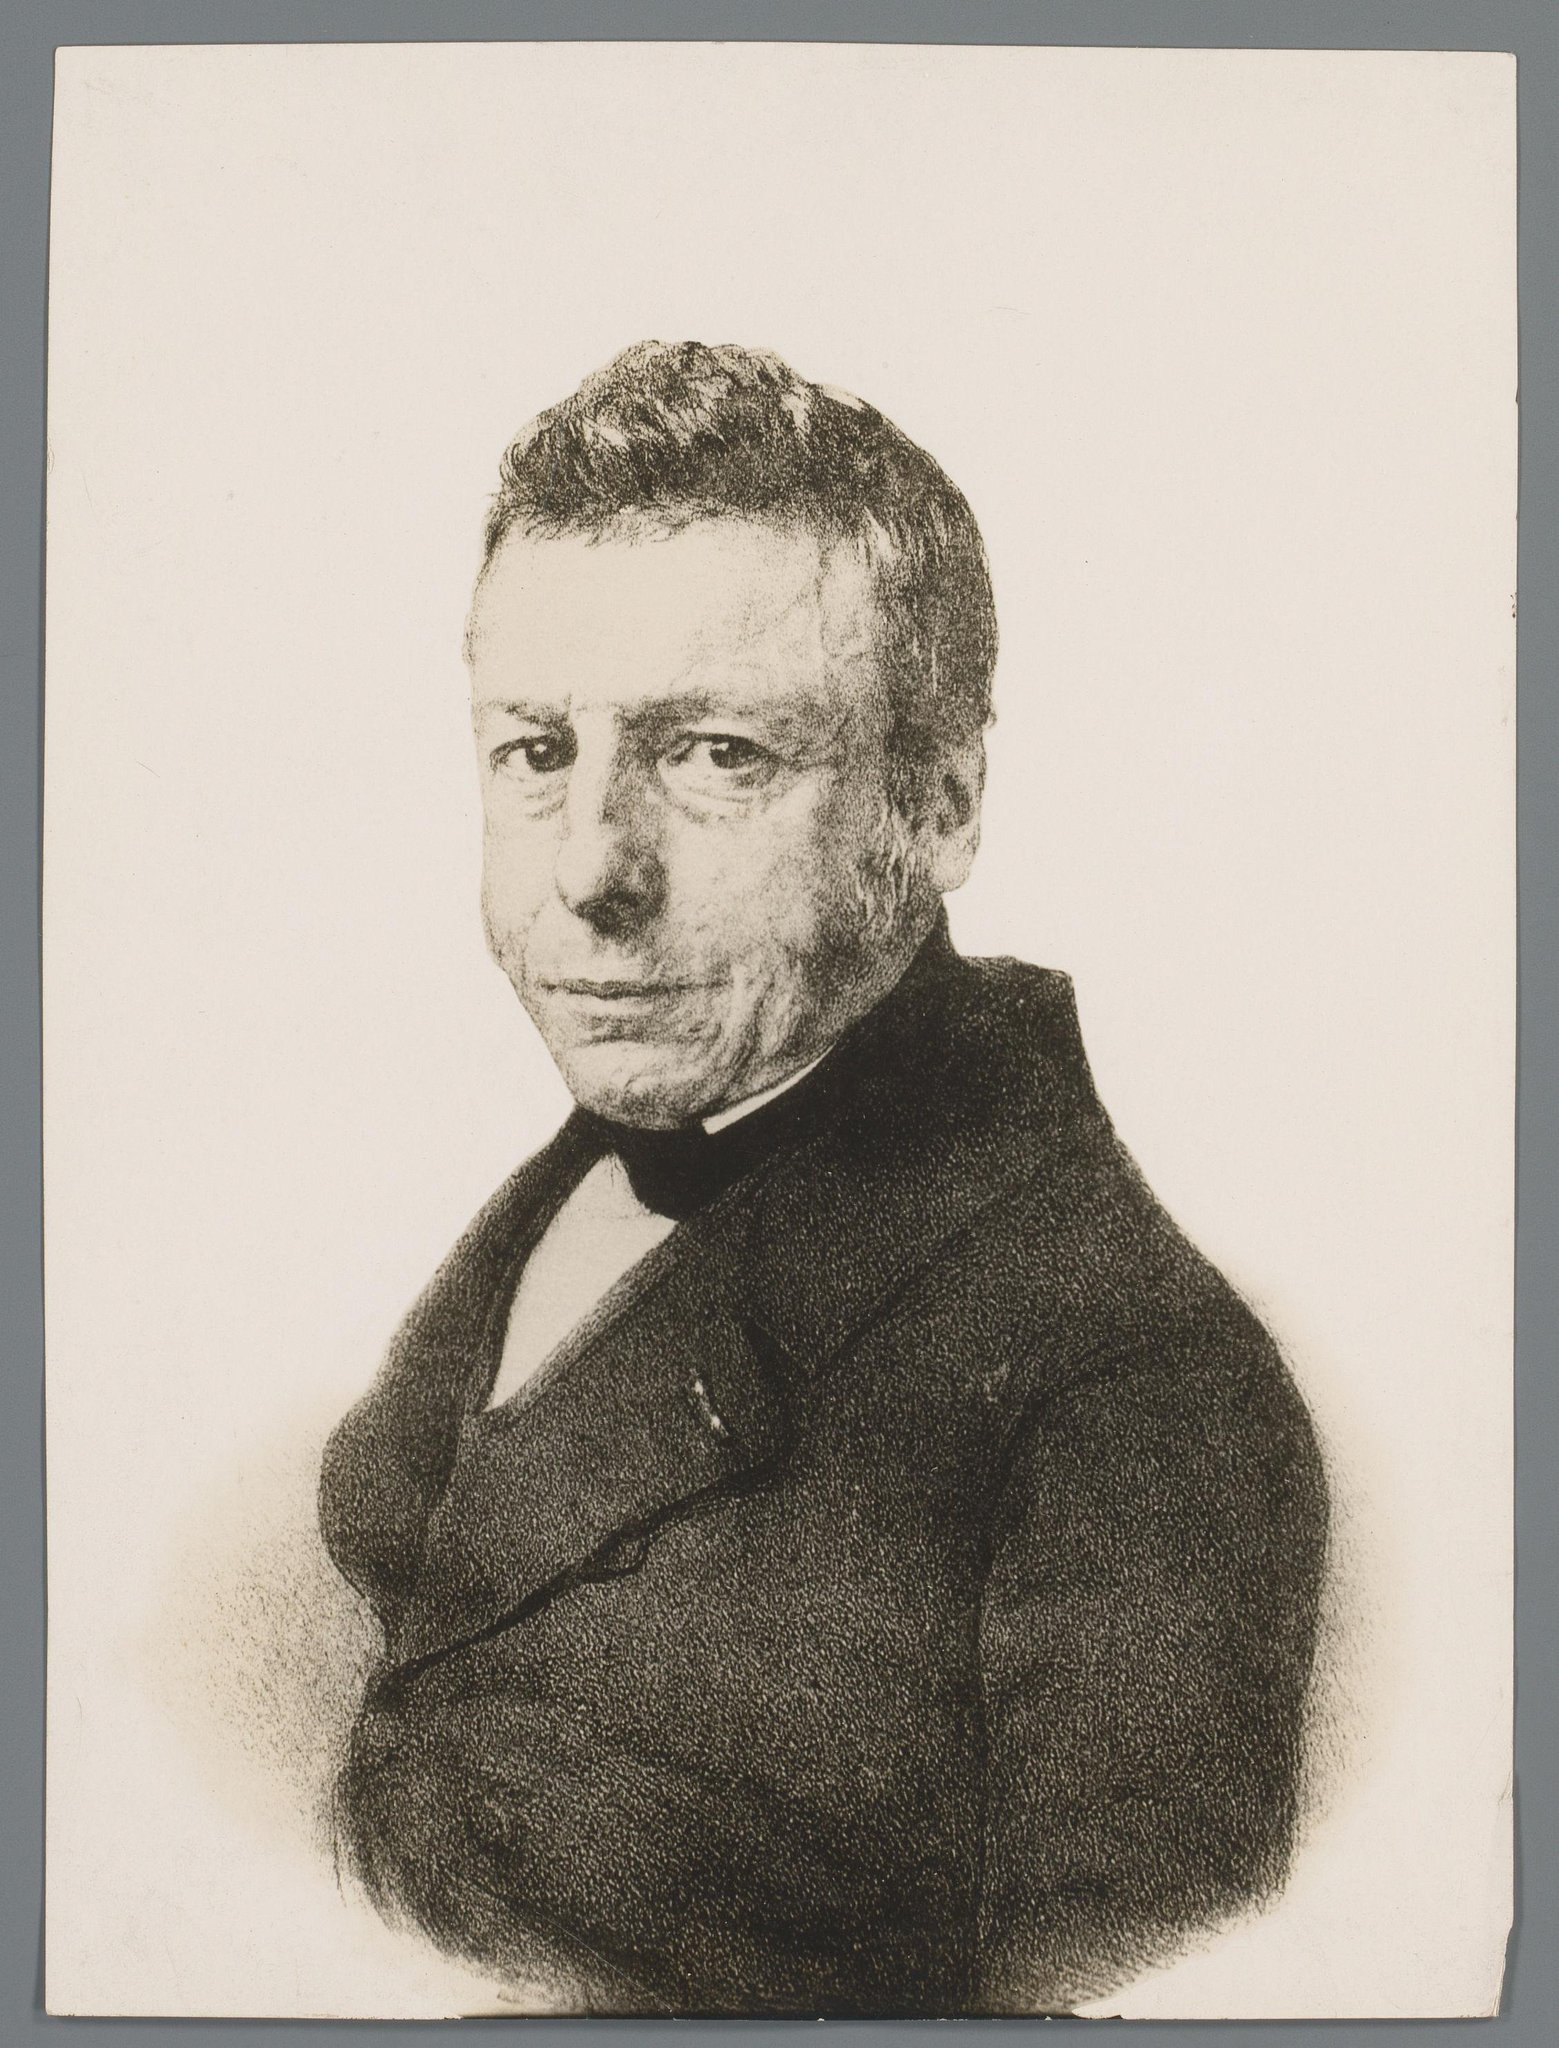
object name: photograph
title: Fotoreproductie van een lithografisch portret van Isaac da Costa door Adrianus Johannus Ehnle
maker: Anonymous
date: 1890-1930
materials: paper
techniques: gelatin silver print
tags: amsterdam, historical persons, writer, poet, author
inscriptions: inscription: ‘da Costa’